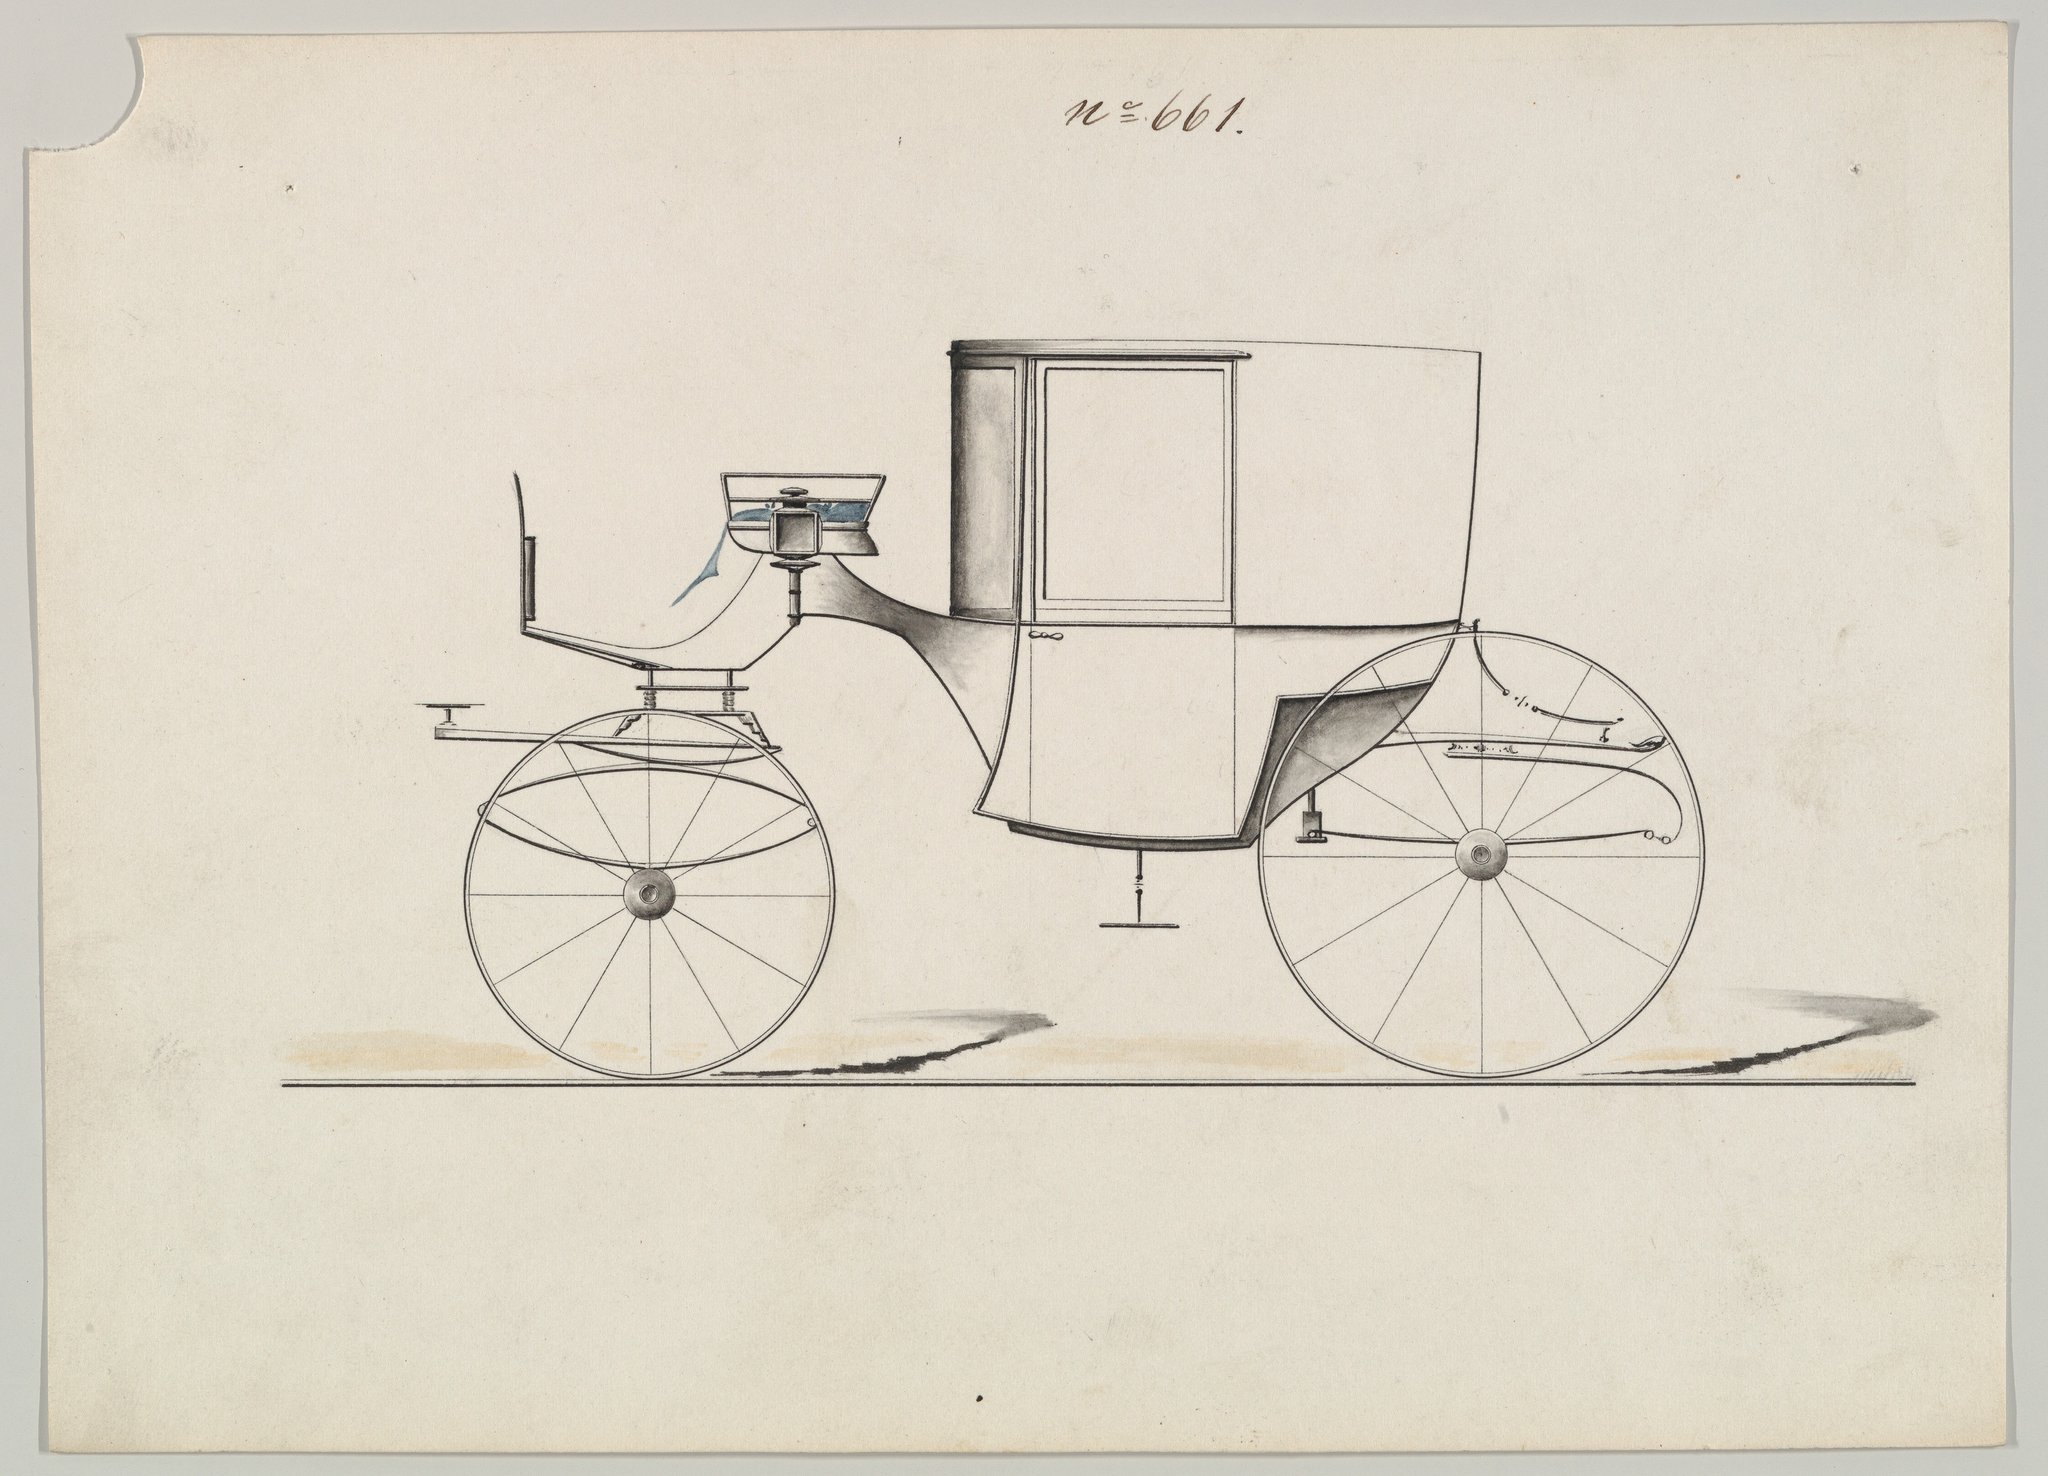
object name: drawing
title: Coupé # 661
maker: brewster & co.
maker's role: manufacturer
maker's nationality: american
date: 1850-1870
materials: gouache, ink, watercolor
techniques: pen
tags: carriages